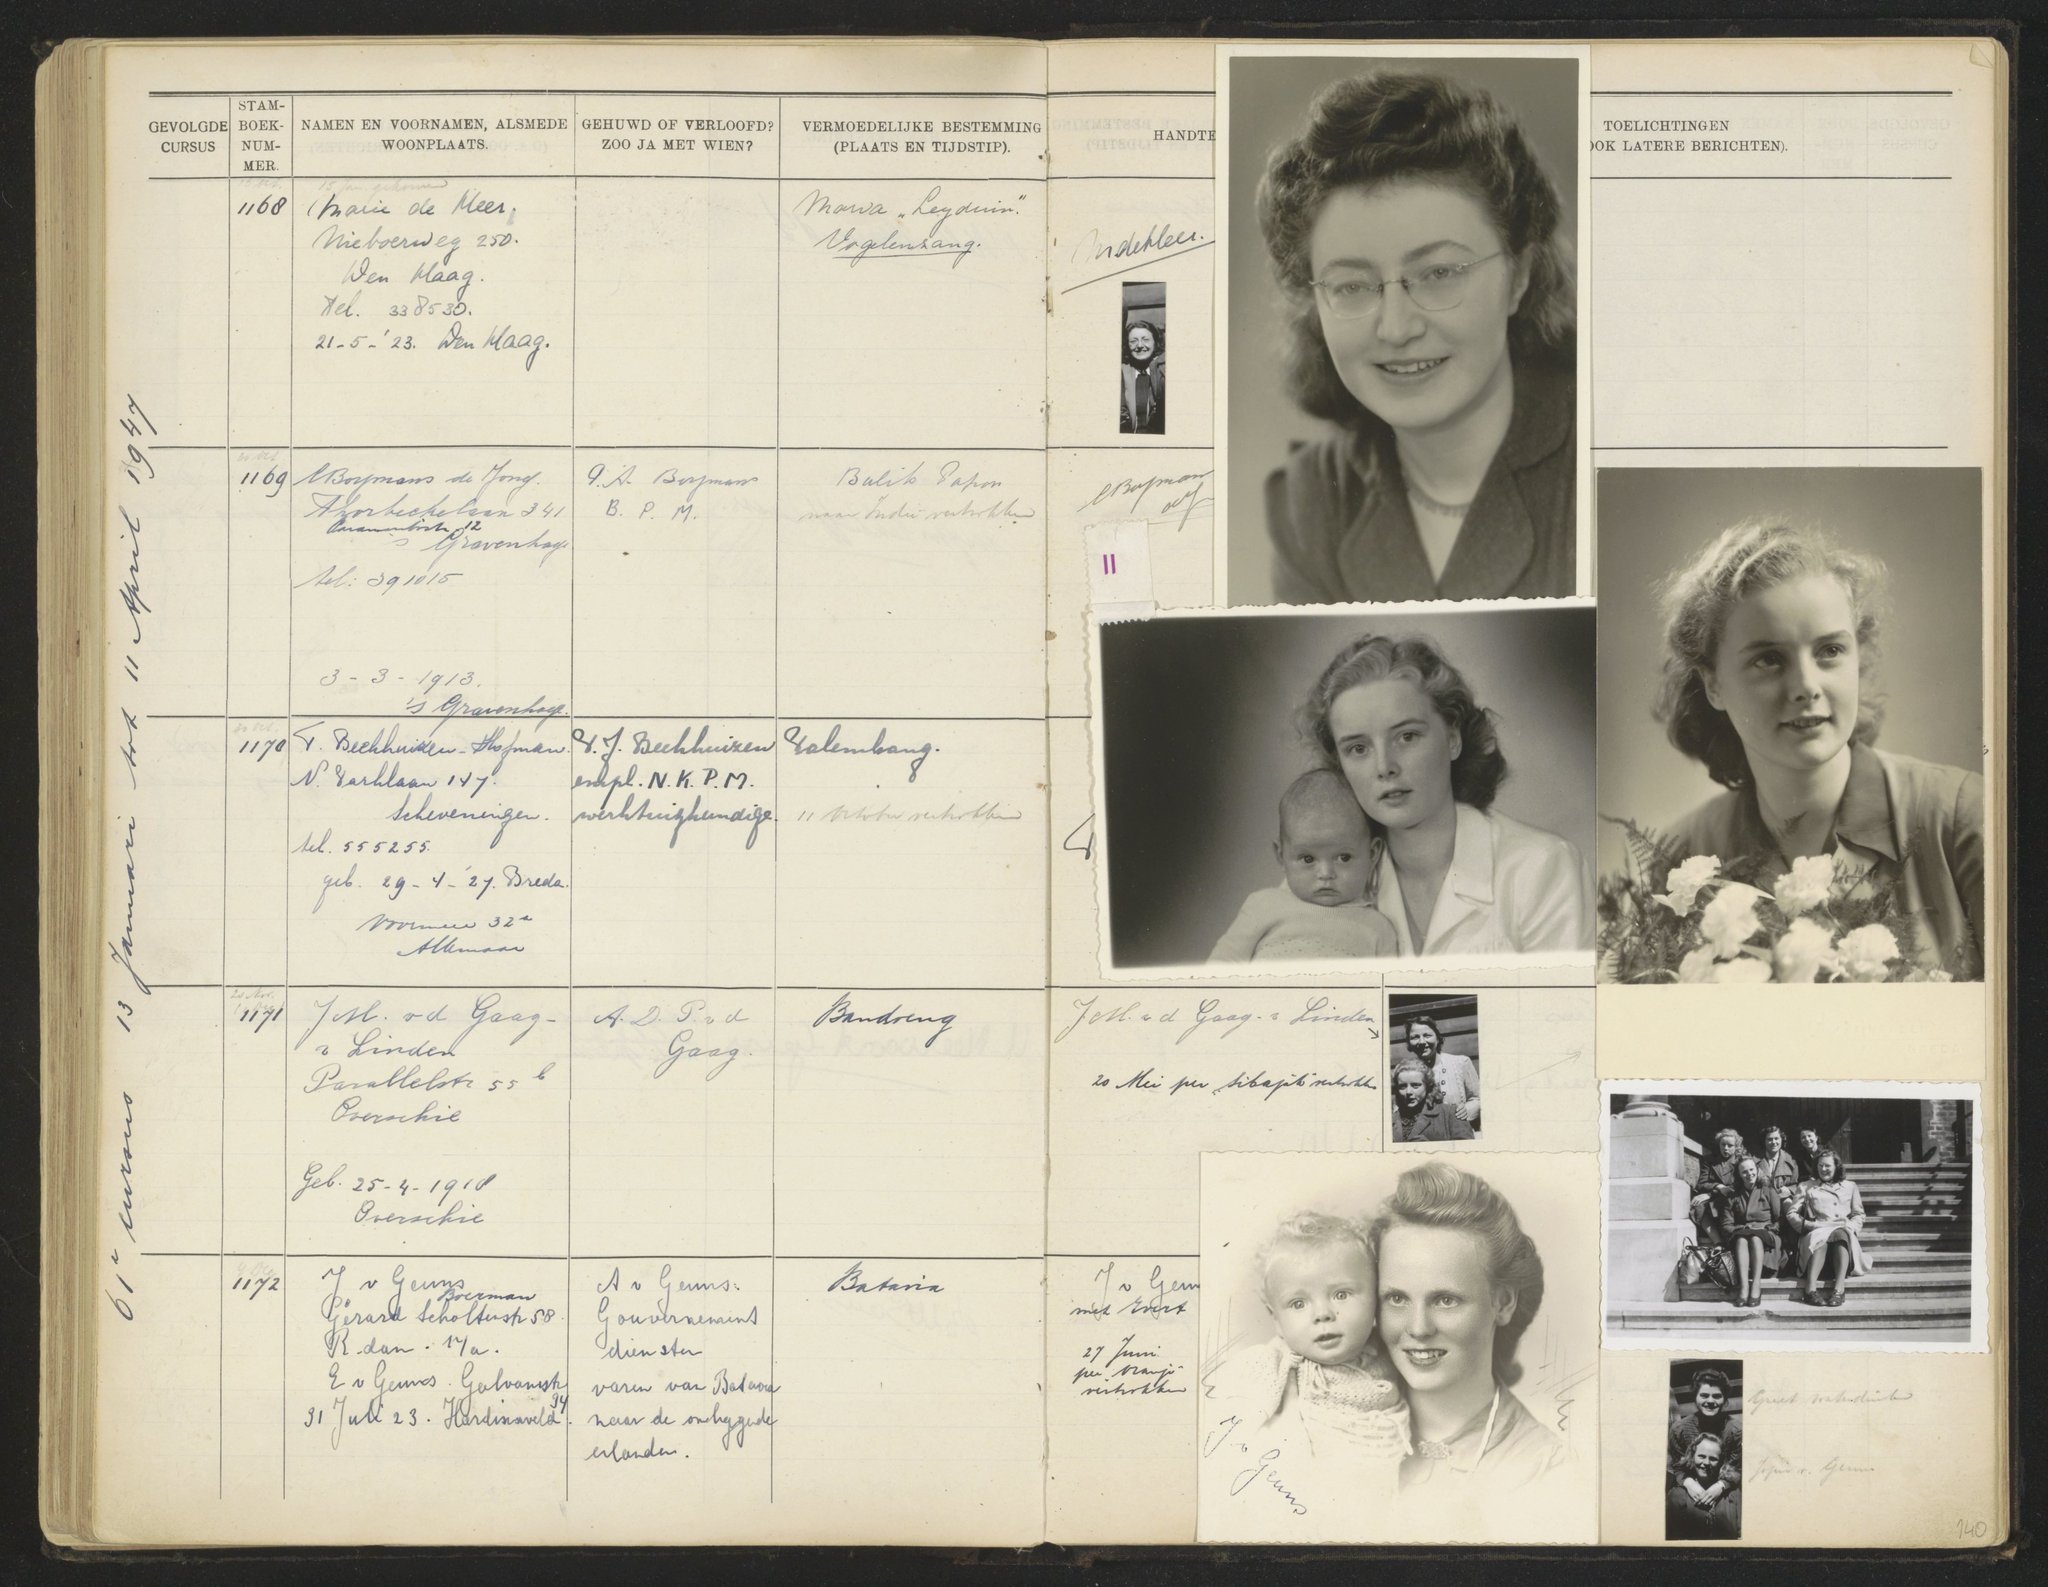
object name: album leaf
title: Blad 140 uit Stamboek van de leerlingen der Koloniale School voor Meisjes en Vrouwen te 's-Gravenhage deel II (1930-1949)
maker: Anonymous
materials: paper, photographic support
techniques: photography, printing, writing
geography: the hague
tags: further education (+ pupil), further education, the hague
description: Twee pagina's met gegevens van de deelnemers aan de 61e driemaandelijkse cursus van 13 januari tot 11 april 1947, stamboeknummers 1168 tot en met 1172. Onderdeel van Stamboek van de leerlingen der Koloniale School voor Meisjes en Vrouwen te 's-Gravenhage deel II (1930-1949).